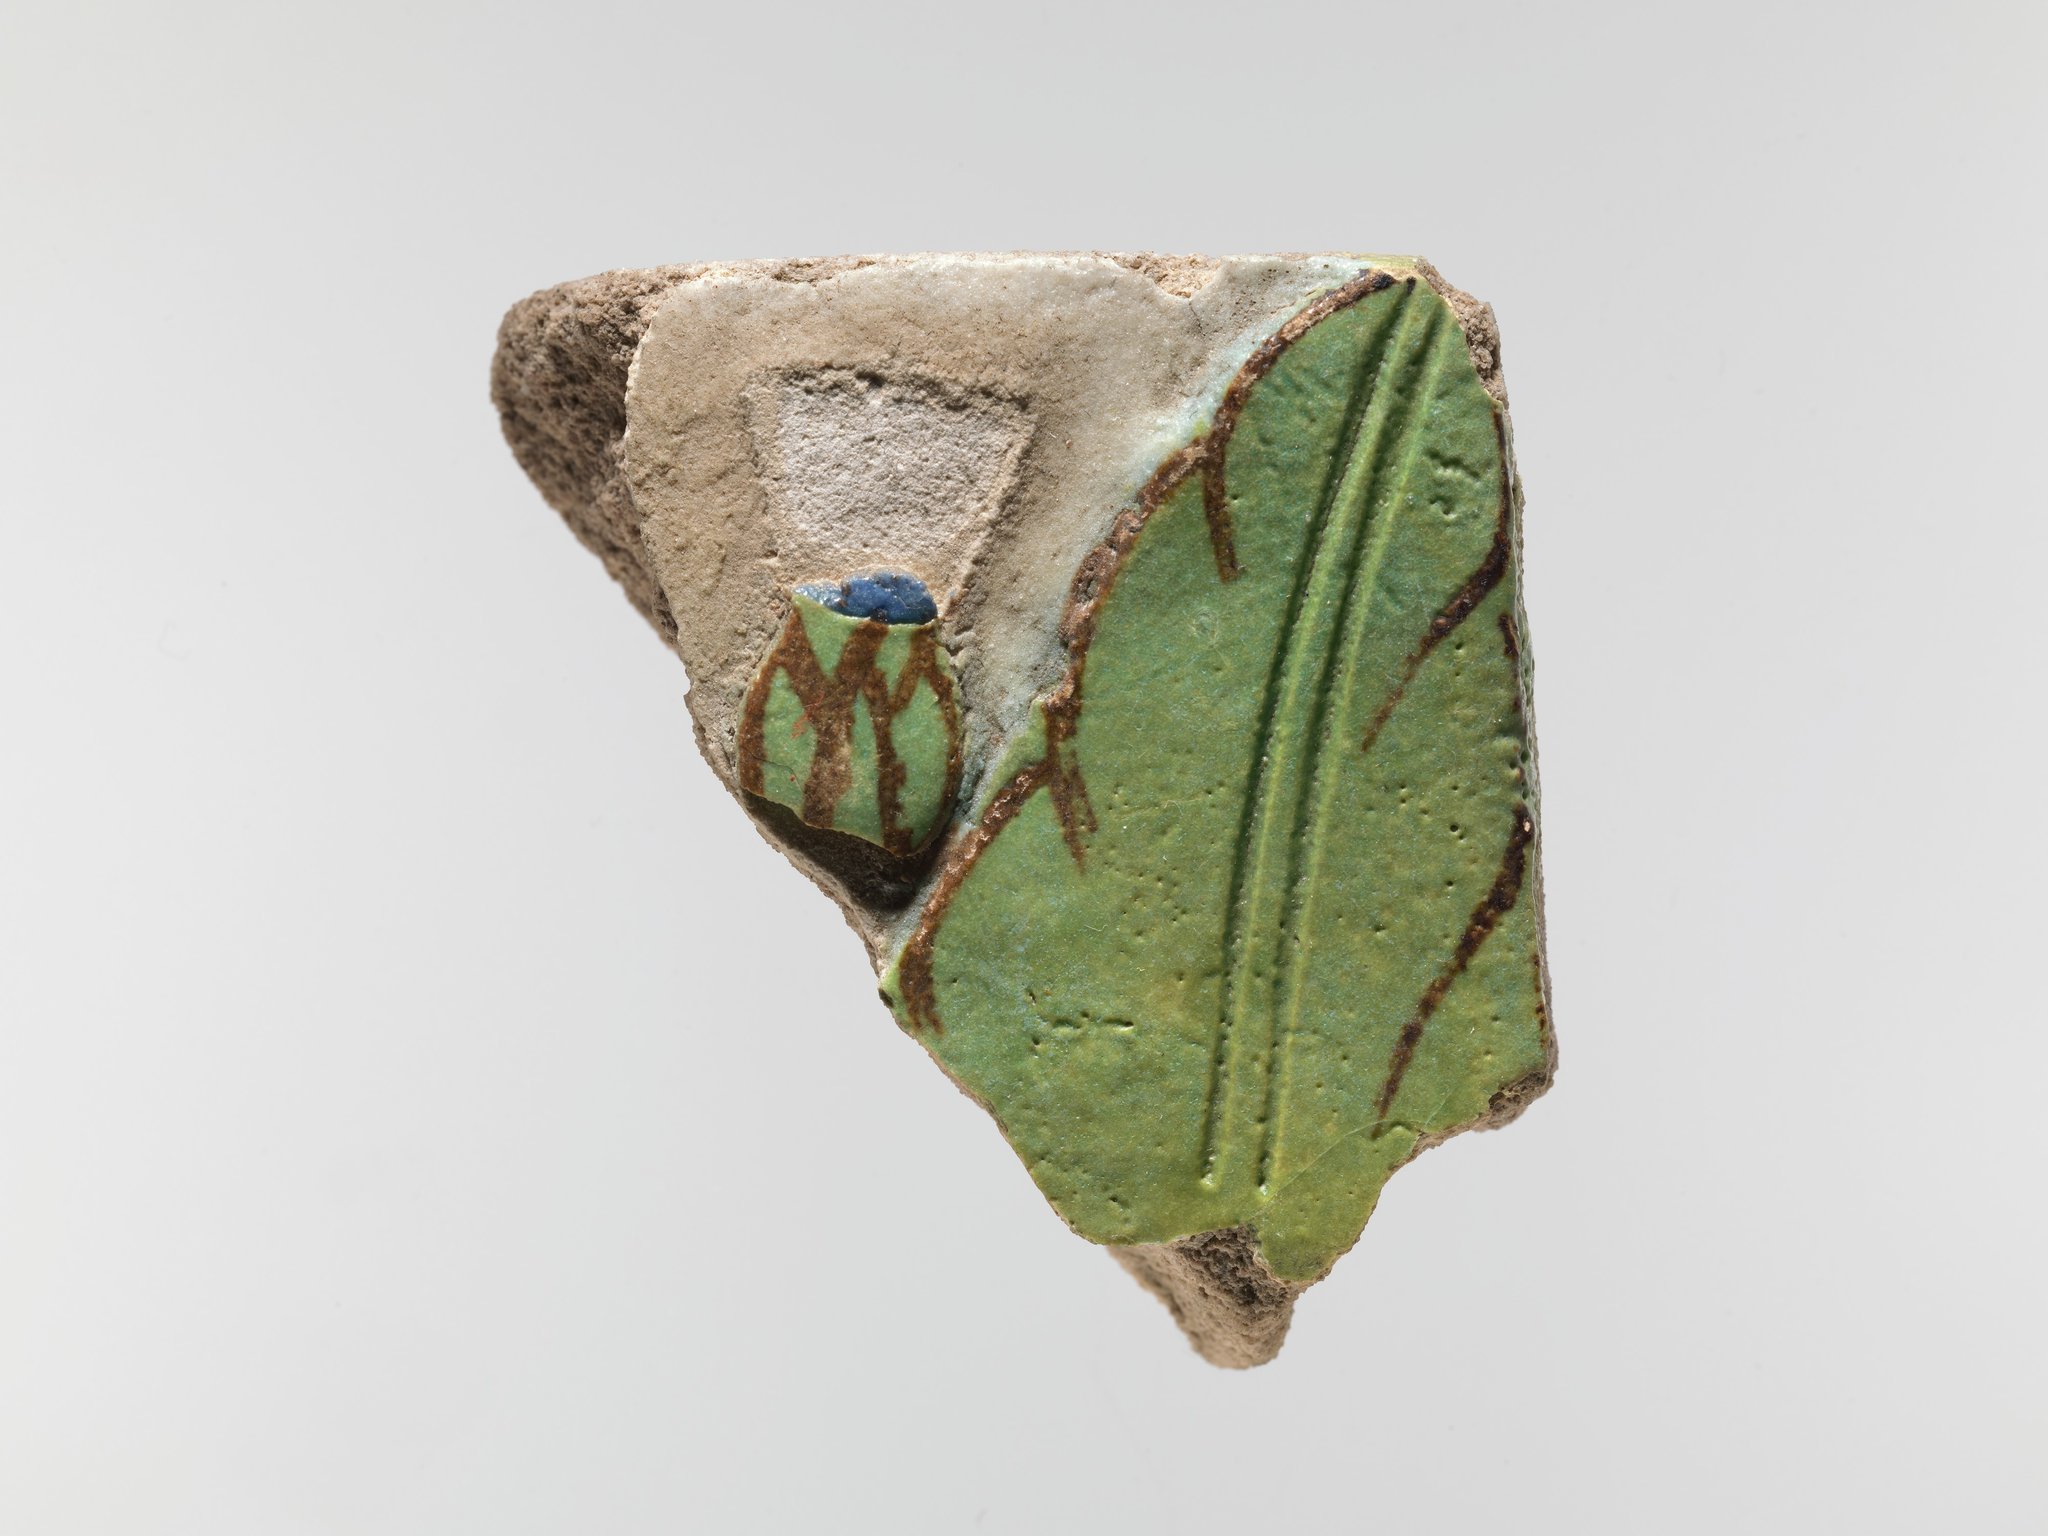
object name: tile fragment, marsh scene, bird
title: Tile from marsh scene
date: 1353-1336 BCE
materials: faience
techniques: polychrome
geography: egypt